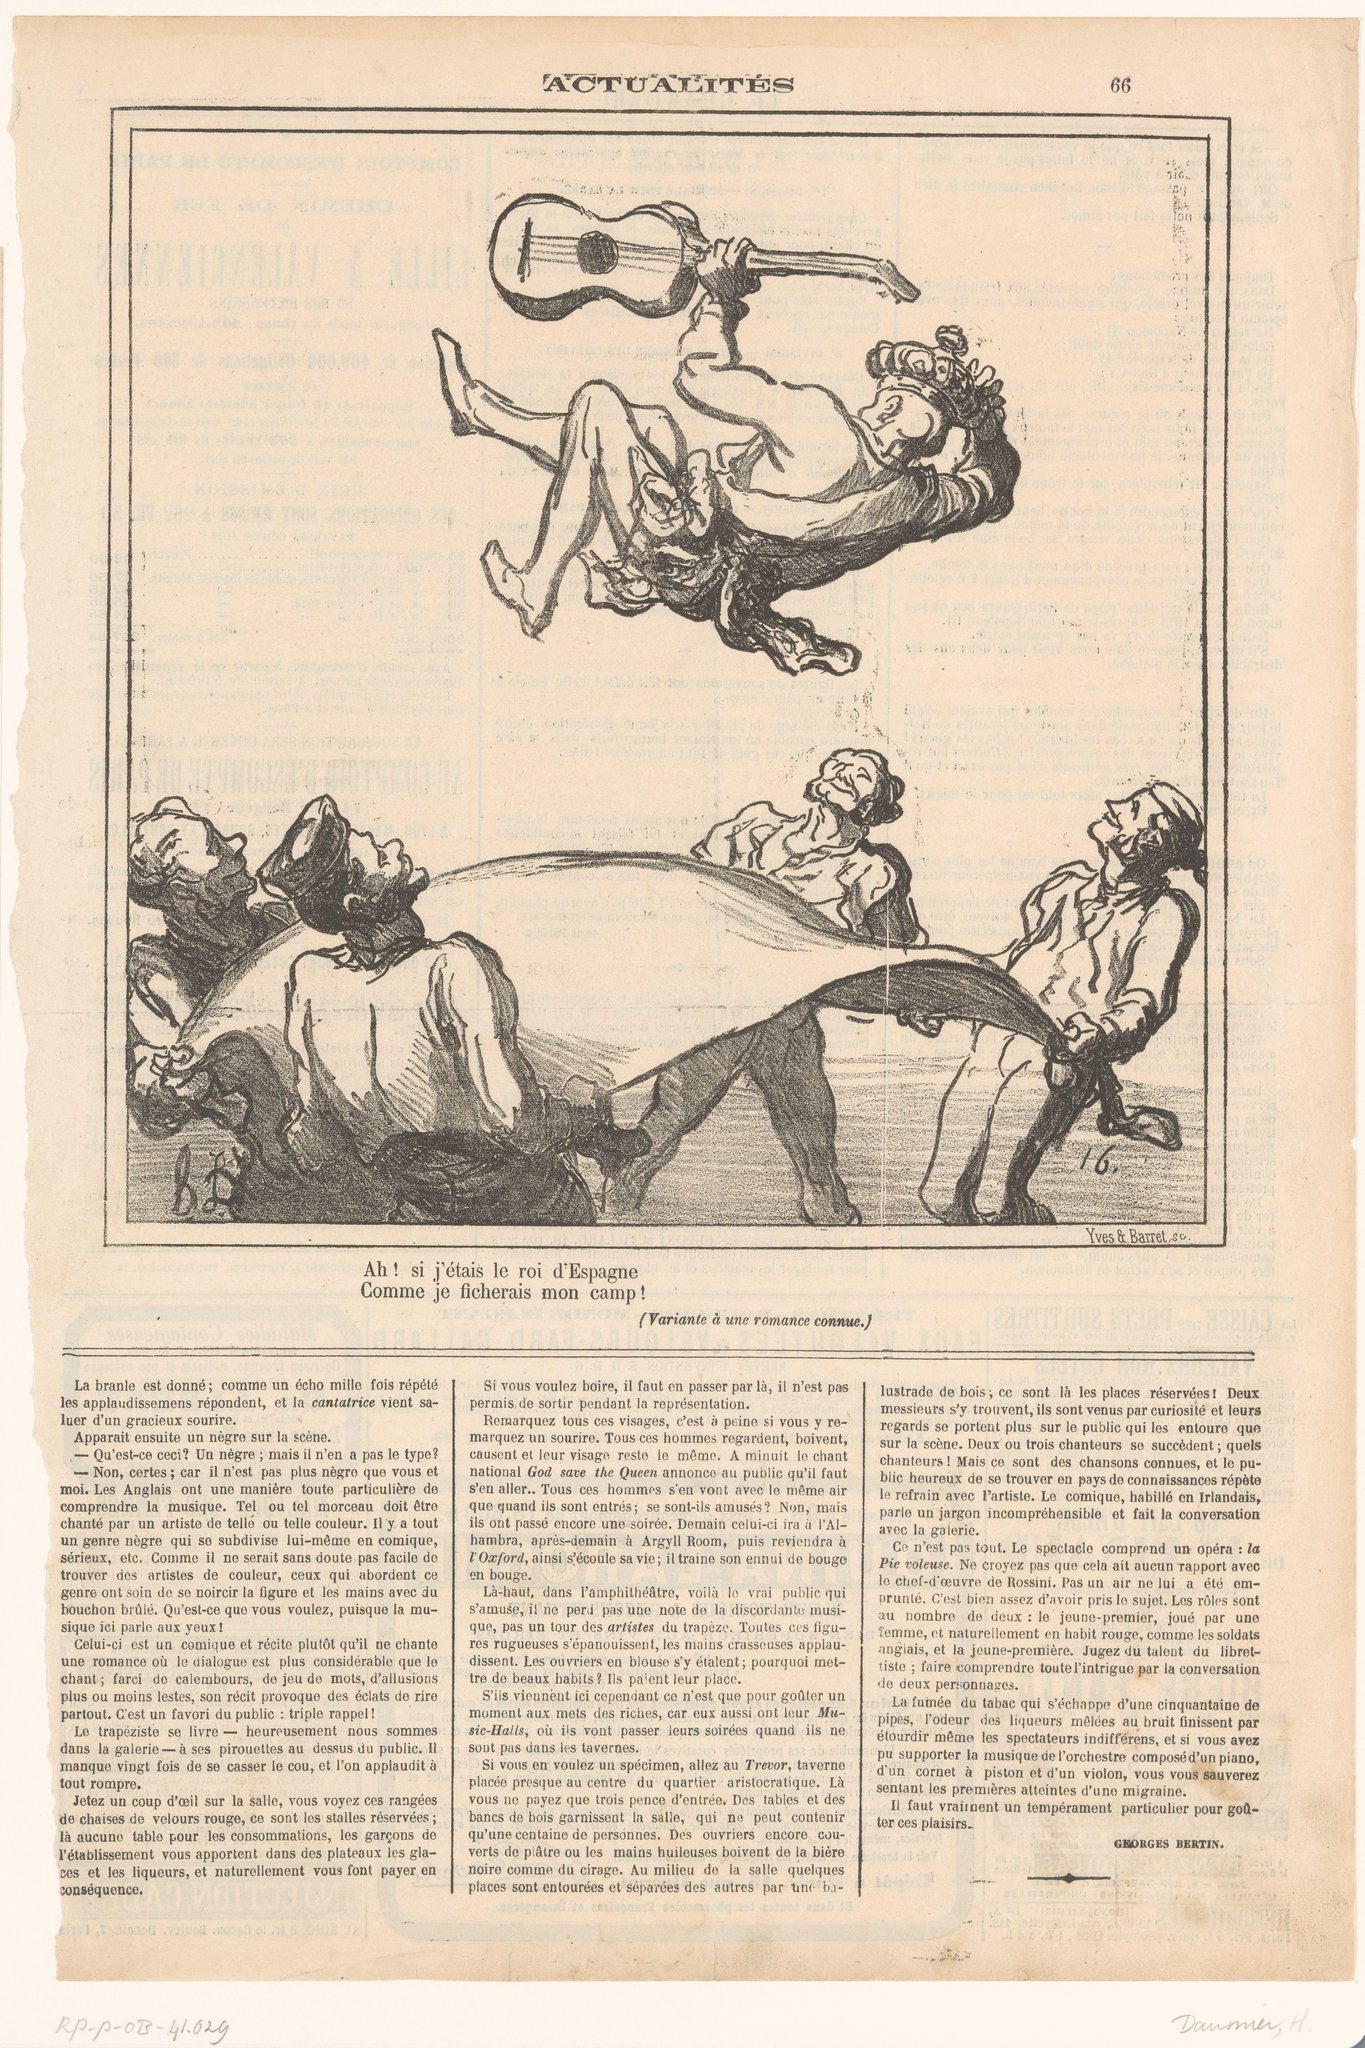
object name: cartoon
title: Vier Spanjaarden gooien hun koning met een laken in de lucht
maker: honoré daumier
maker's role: draughtsman, painter, print maker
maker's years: 1808-1879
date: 1872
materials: paper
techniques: lithograph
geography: paris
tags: europeans: spaniards, caricatures (human types), king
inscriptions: collector's mark: Lugt 2228a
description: Prent gebruikt voor: Le Charivari, 9 april 1872.